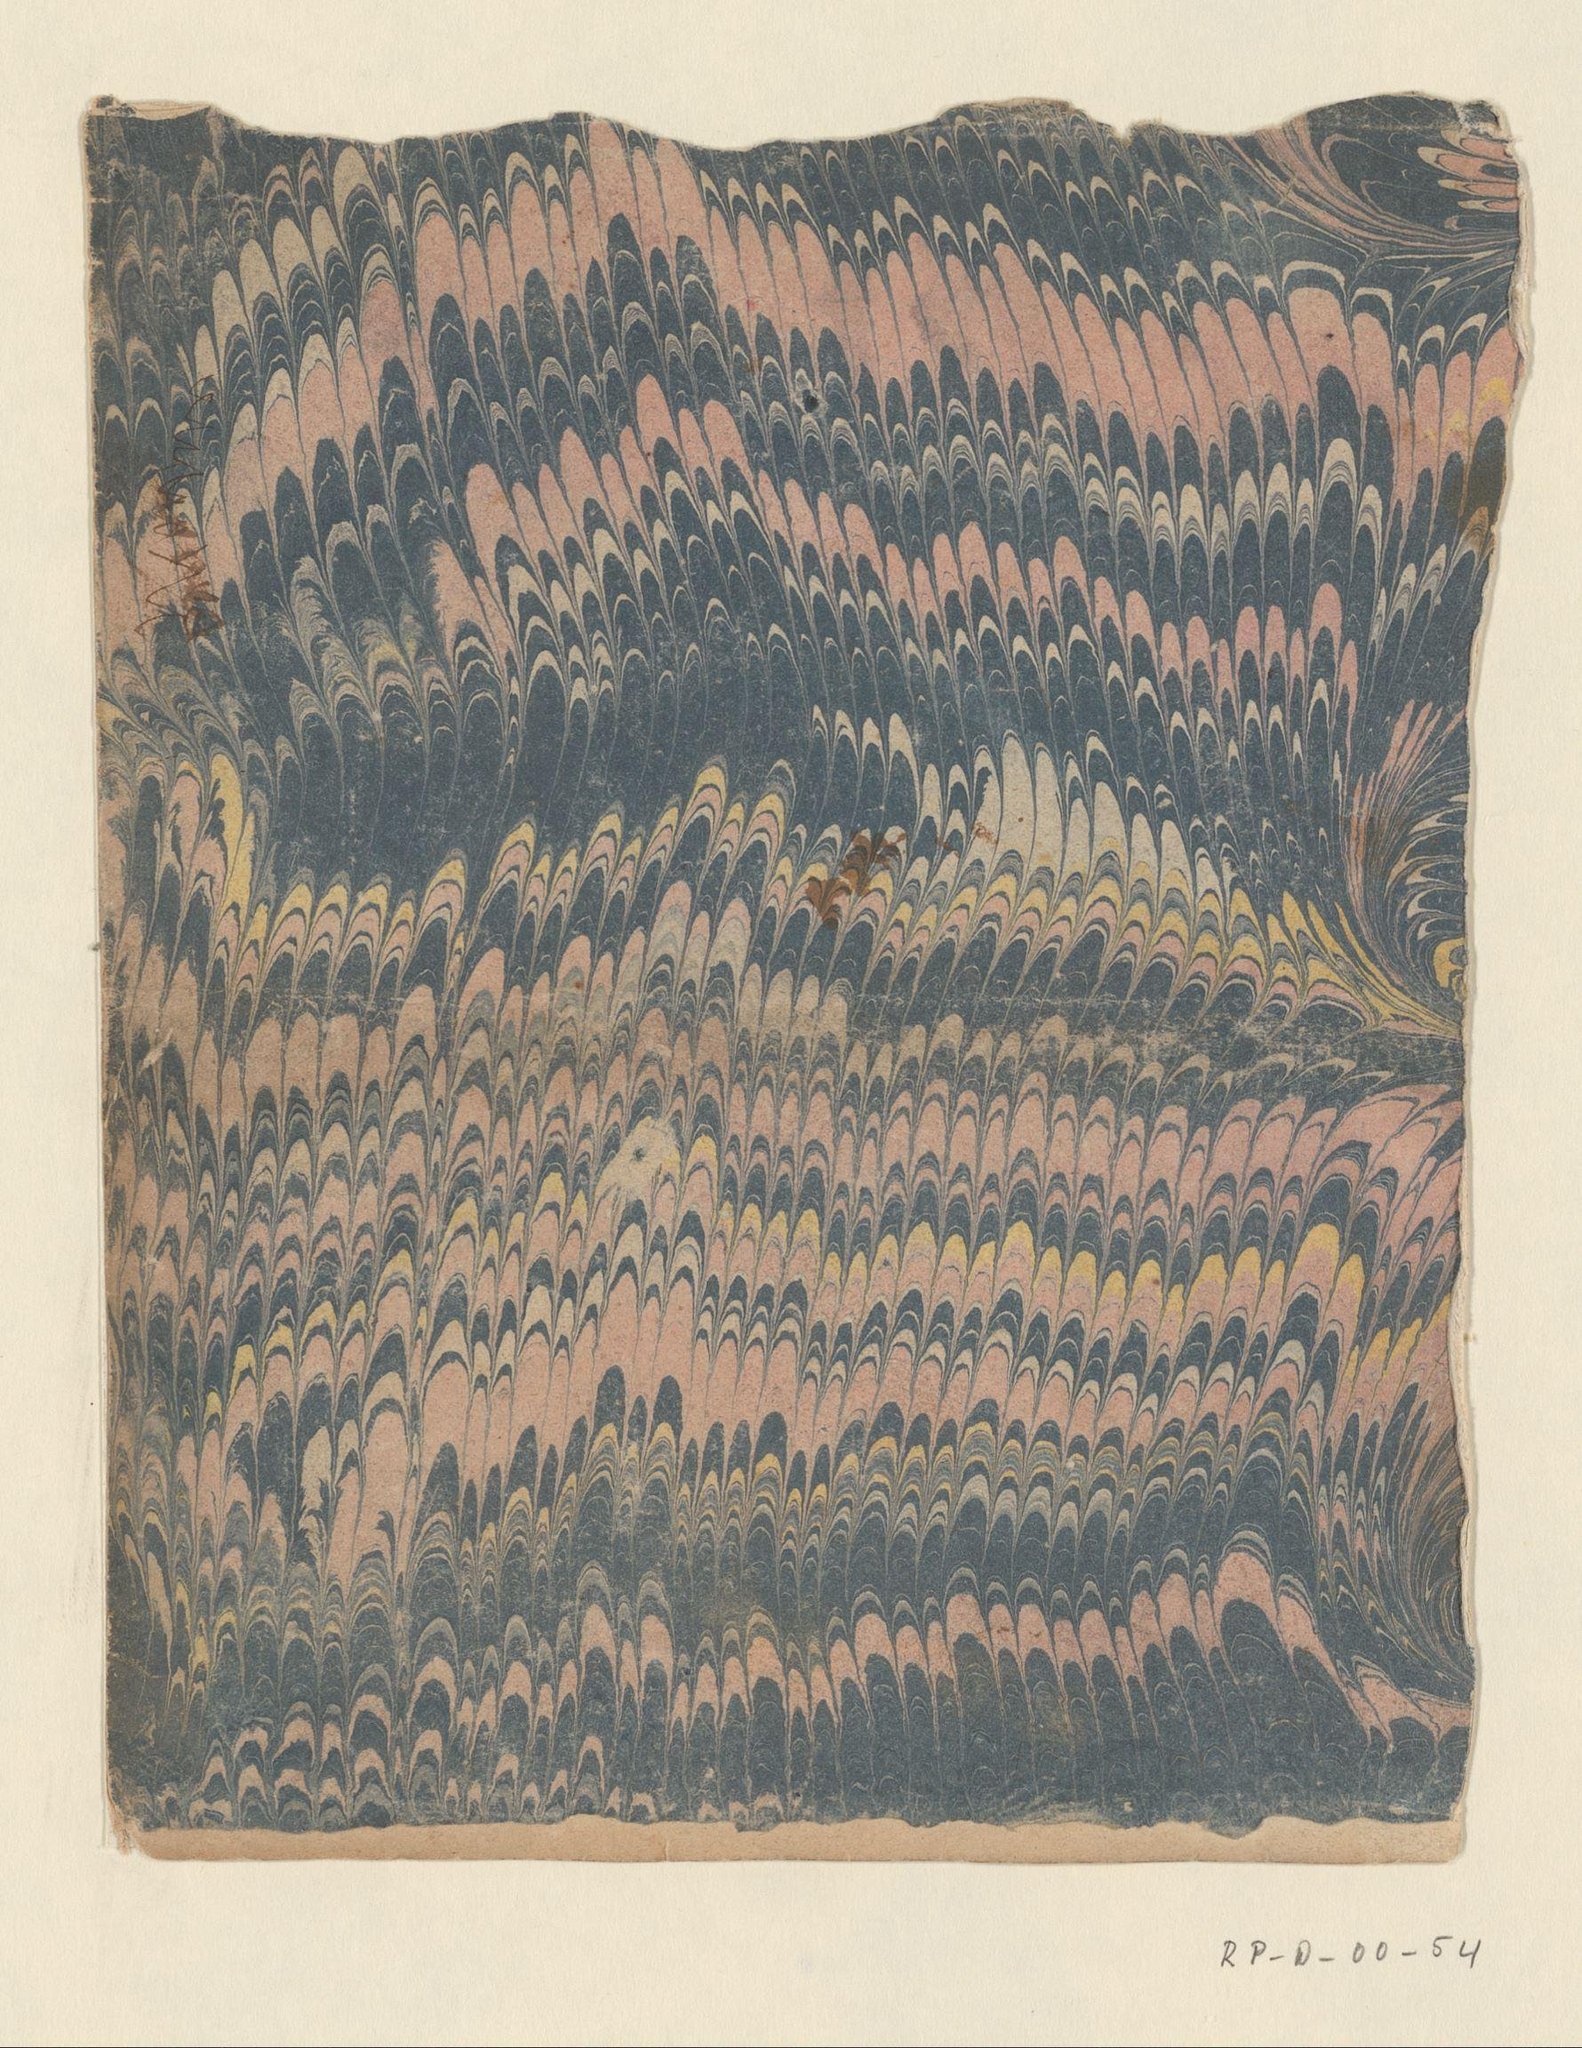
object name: marbled paper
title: Kammarmer in roze, blauw en geel met opschrift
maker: Anonymous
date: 1700-1850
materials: paint, paper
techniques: marbled paper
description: Kammarmer in roze, blauw en geel. Gebruikt als omslag met (op verso) opschrift in pen: 'omslag van papier van 1650'.